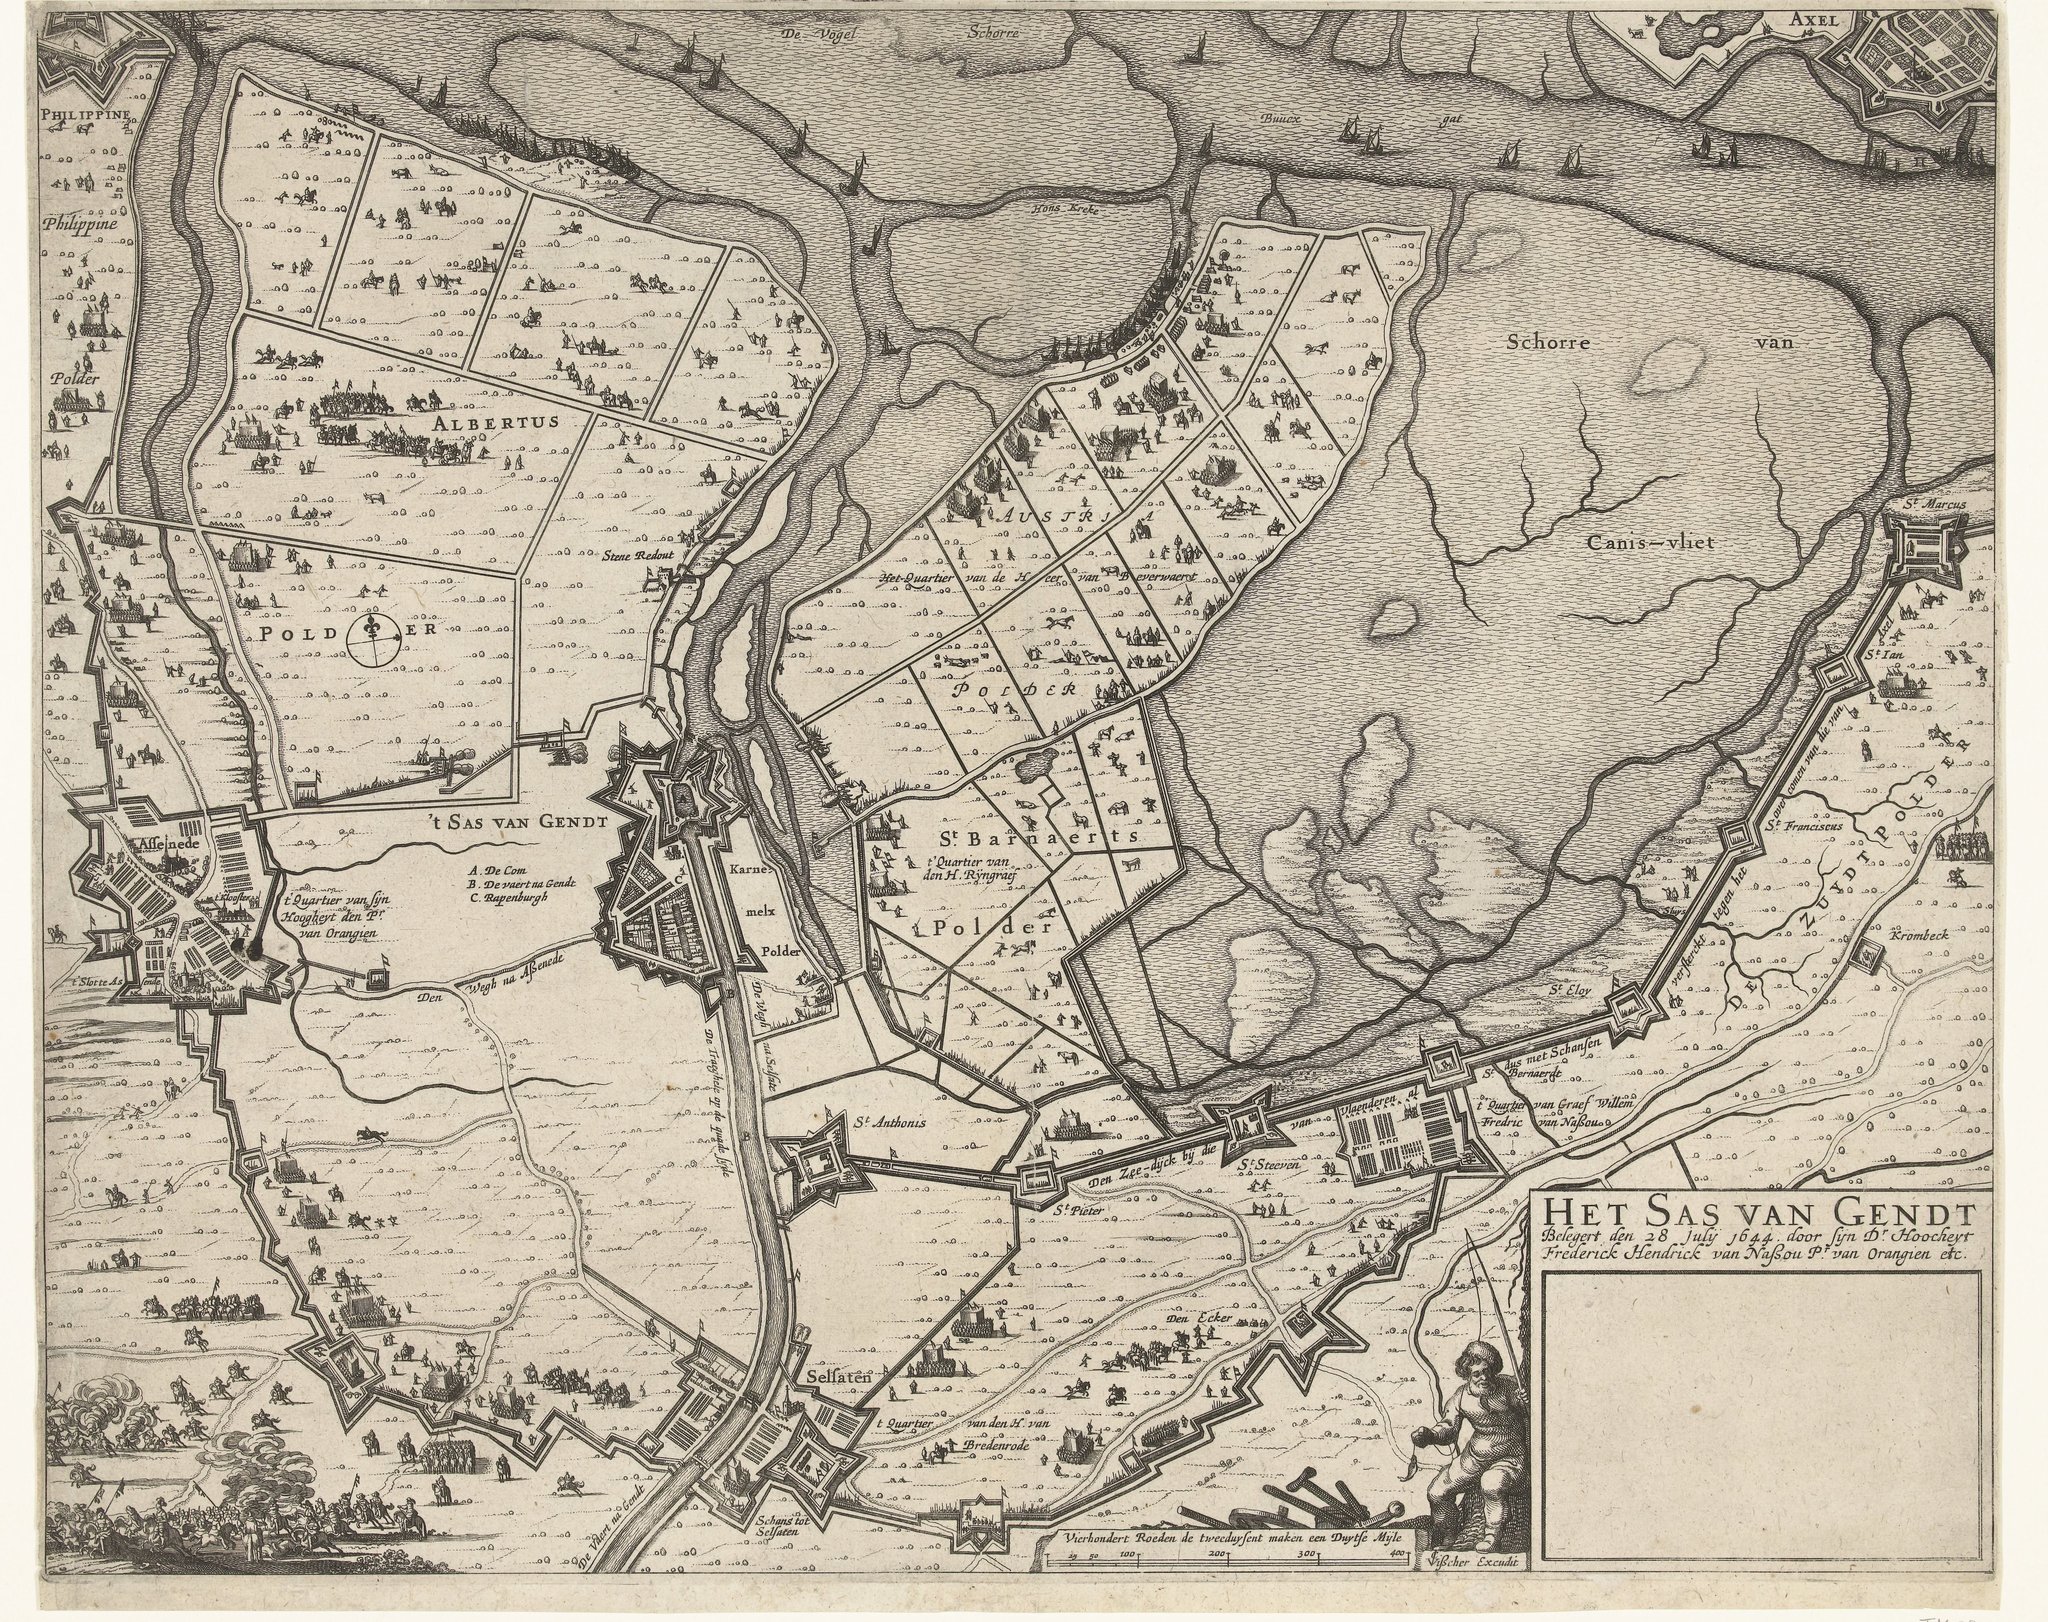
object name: print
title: Het Sas van Gendt Belegert den 28 July 1644 door syn Dr. Hoocheyt Frederick Hendrick van Nassou Pr. van Orangien etc.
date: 1644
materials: paper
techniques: etching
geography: northern netherlands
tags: frederick henry (prince of orange), maps of separate countries or regions, siege, position war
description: Kaart van het beleg van de stad Sas-van Gent door het Staatse leger onder Frederik Hendrik, begonnen 28 juli 1644. Kaart van Sas-van-Gent en het omliggende land tussen Philippine, Axel en Zelzate met de dijken en schansen aangelegd door de belegeraars en hun legerkampen. Rechtsonder een cartouche met de titel, verder leeg. Bij de prent behoort een tekstblad in het Nederlands (met laatst vermelde datum 8 augustus).